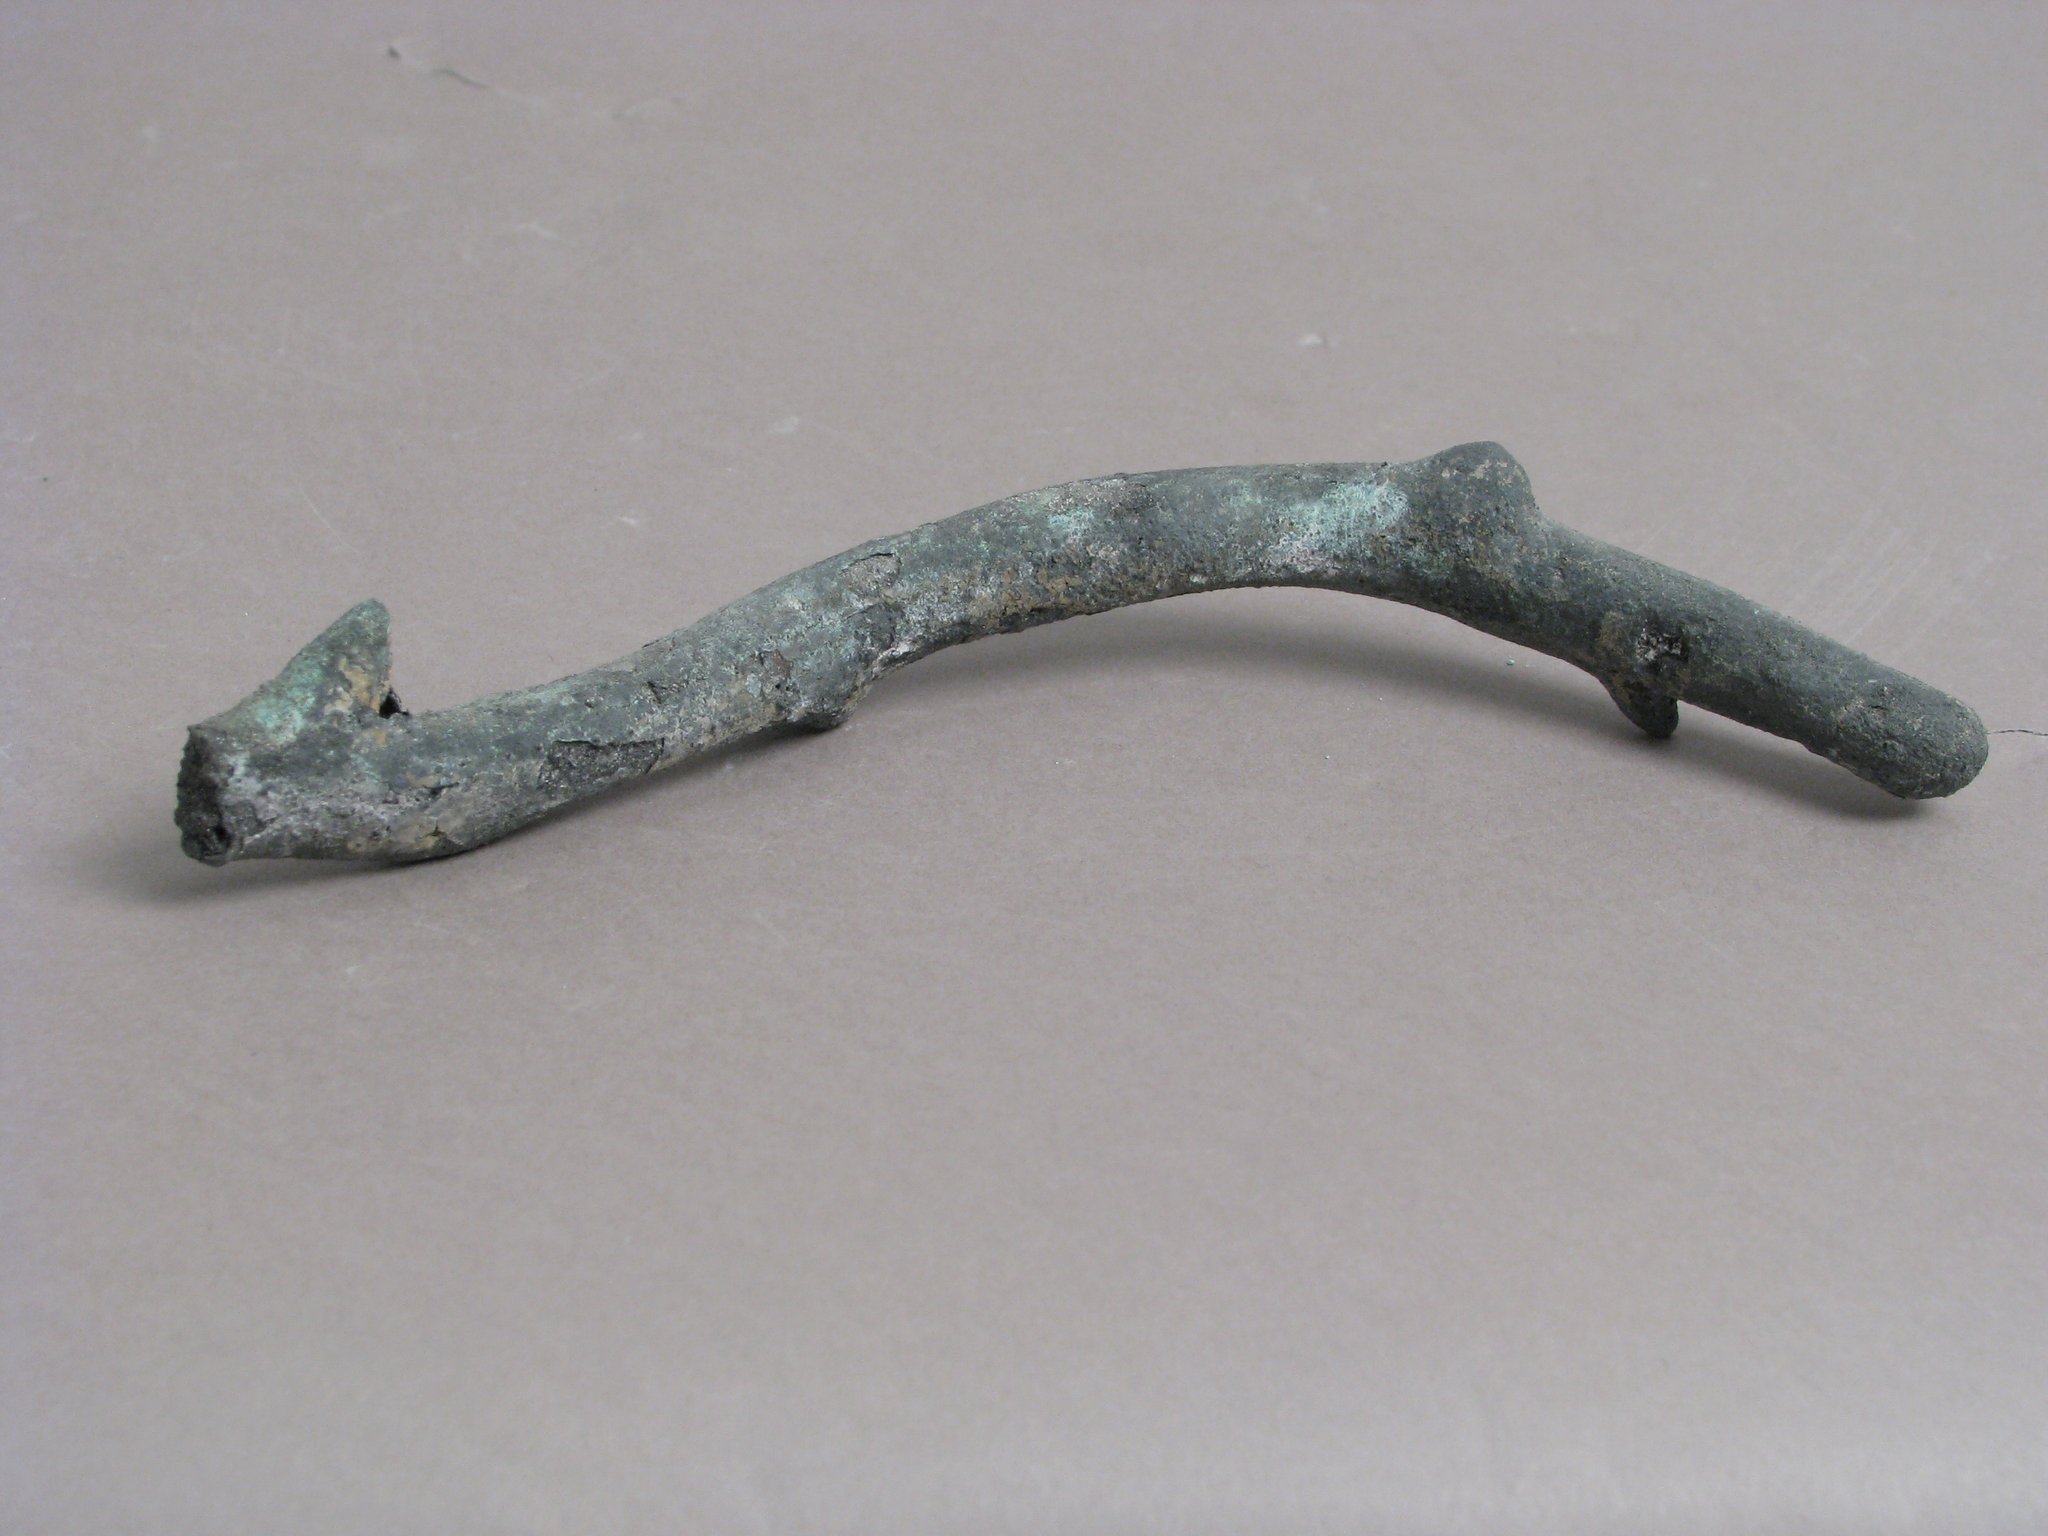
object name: handle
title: Handle (?)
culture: coptic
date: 301-700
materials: metal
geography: egypt